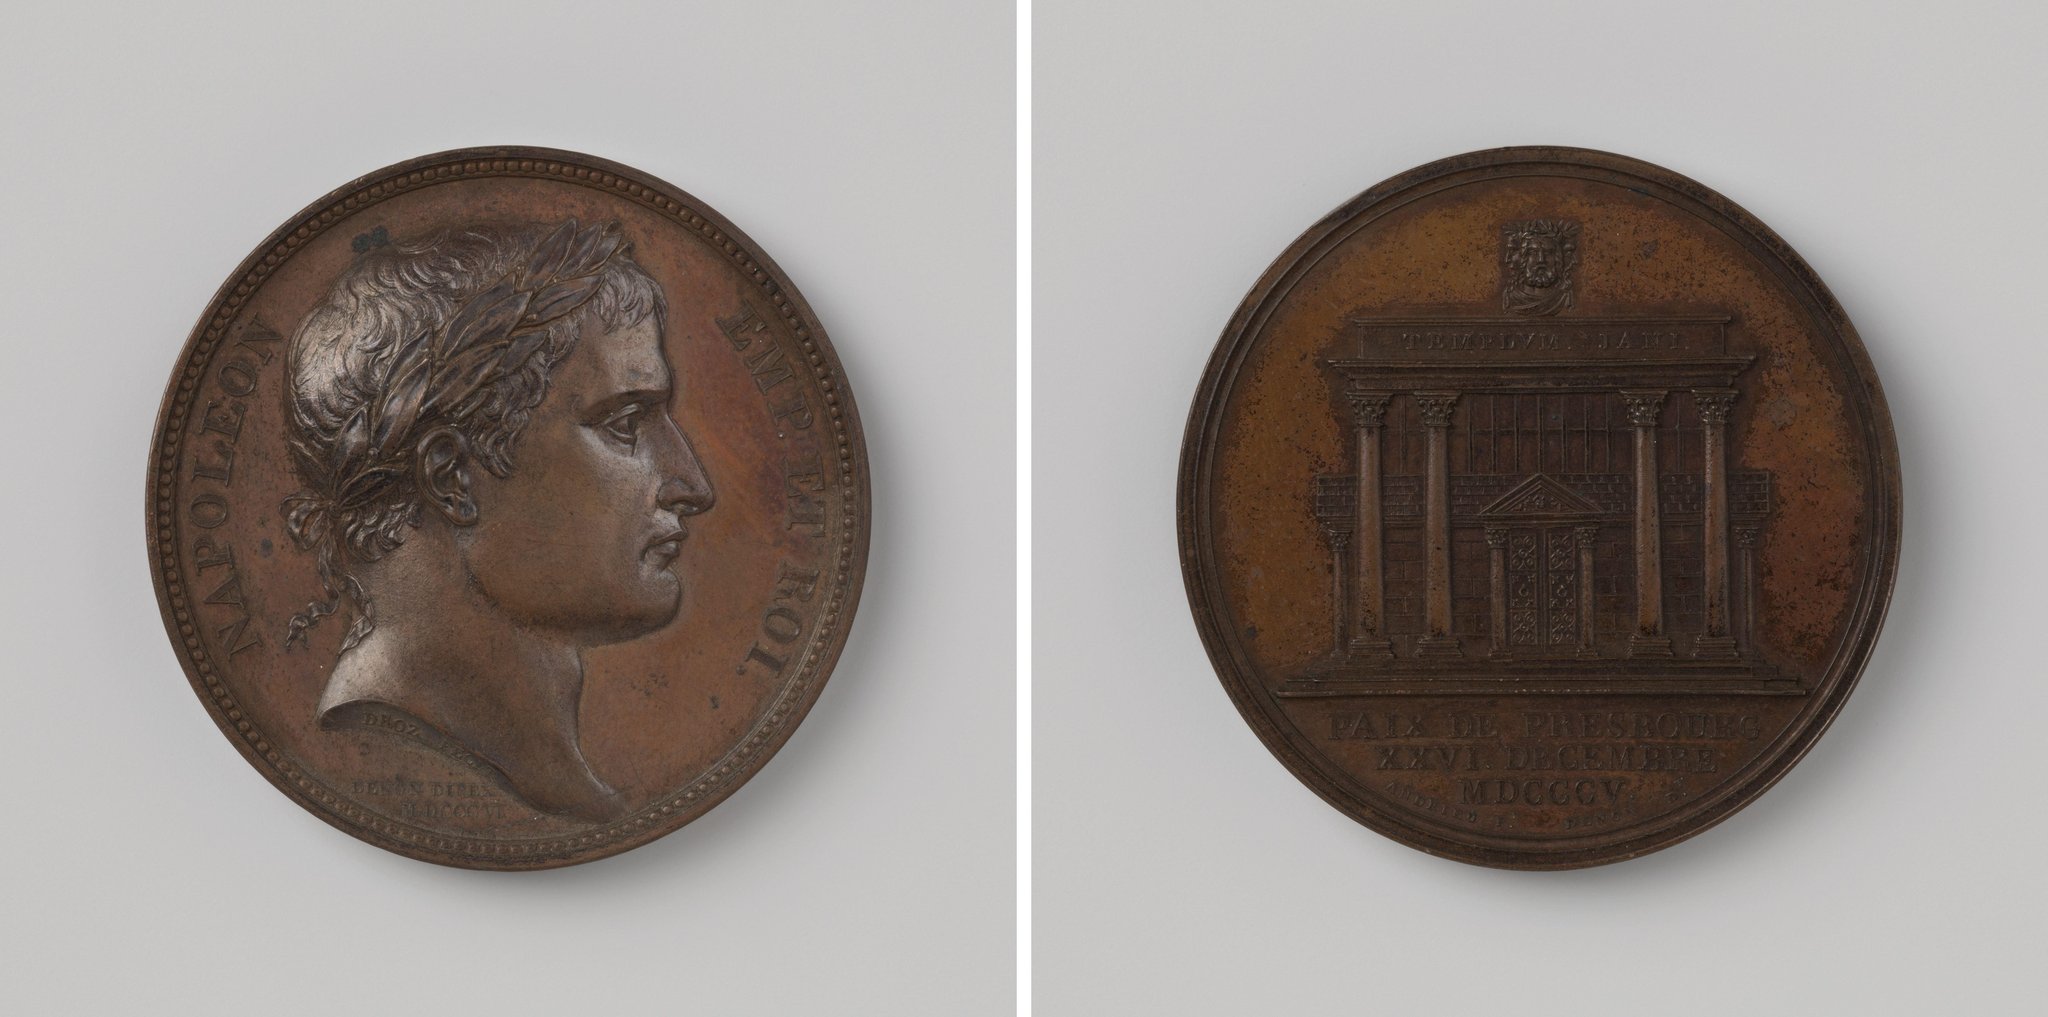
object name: history medal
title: Vrede van Pressburg tussen Oostenrijk en Frankrijk, ter ere van Napoleon I Bonaparte, keizer der Fransen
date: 1805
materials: bronze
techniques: striking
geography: paris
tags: napoleon i (emperor of the french)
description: Bronzen penning. Voorzijde: borststuk man met lauwerkrans binnen omschrift. Keerzijde: gesloten tempel van Janus; afsnede: opschrift